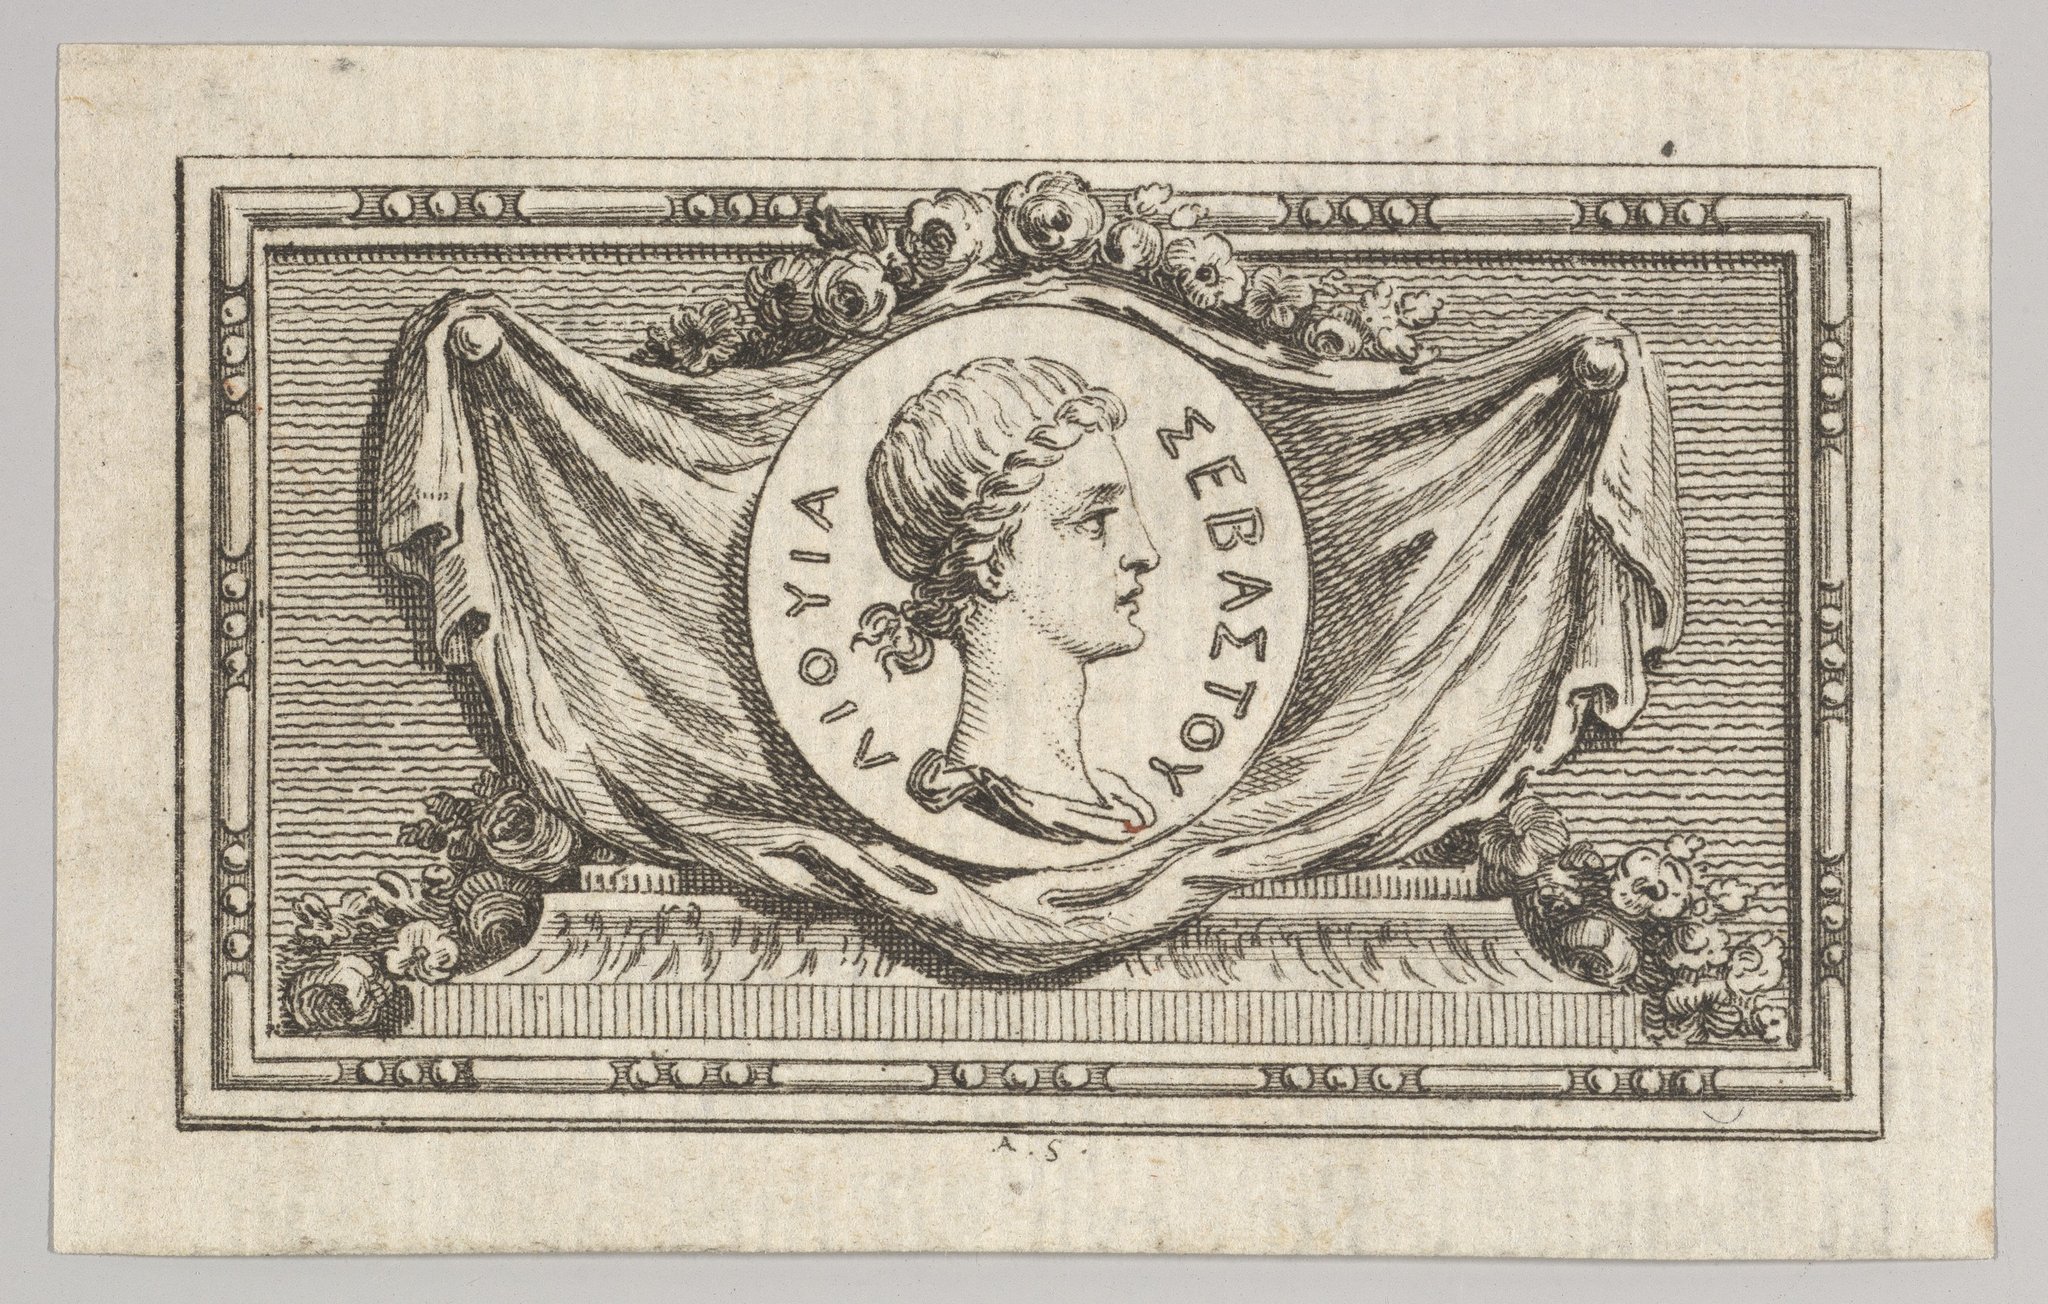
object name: print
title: Medal with Portrait of Livy in the 5th Book, from Tibère ou les six premiers livres es Annales de Tacite Traduits par M. l'abbé de la Bléterie Professeur d'Eloquence au Collège Royal et de l'Académie Royale des Inscriptions et Belles-lettres. A Paris de l'Imprimerie Royale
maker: augustin de saint-aubin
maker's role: artist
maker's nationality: french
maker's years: 1736-1807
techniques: engraving, etching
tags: men,profiles,medals